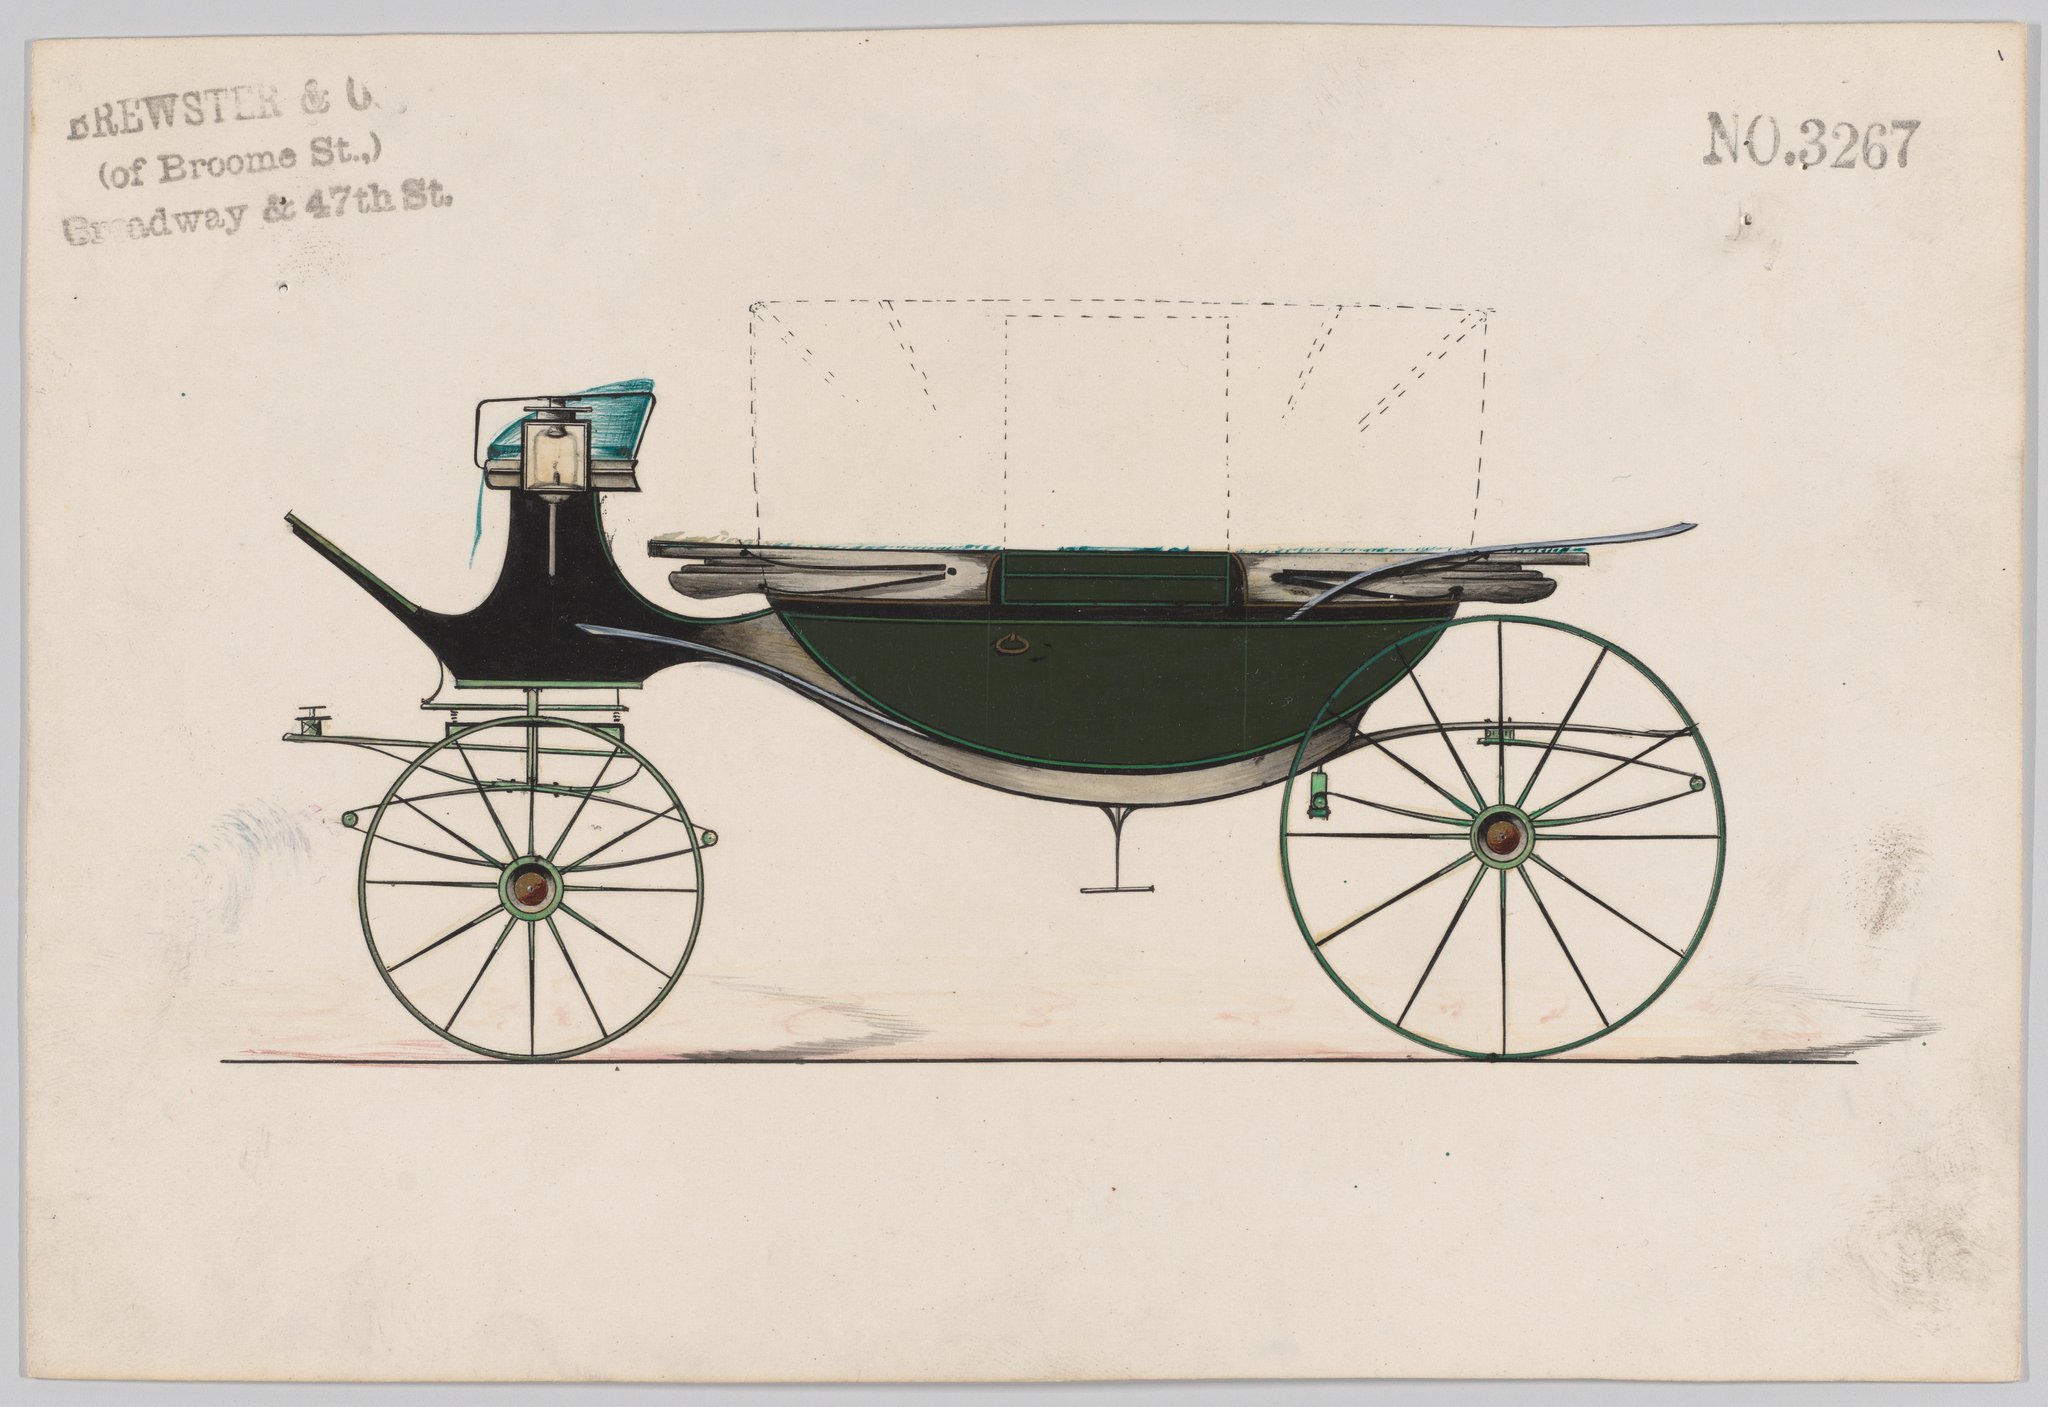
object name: drawing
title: Design for Landau, No. 3267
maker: brewster & co.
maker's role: manufacturer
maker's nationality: american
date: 1876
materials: gouache, gum arabic, ink, watercolor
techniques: pen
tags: carriages